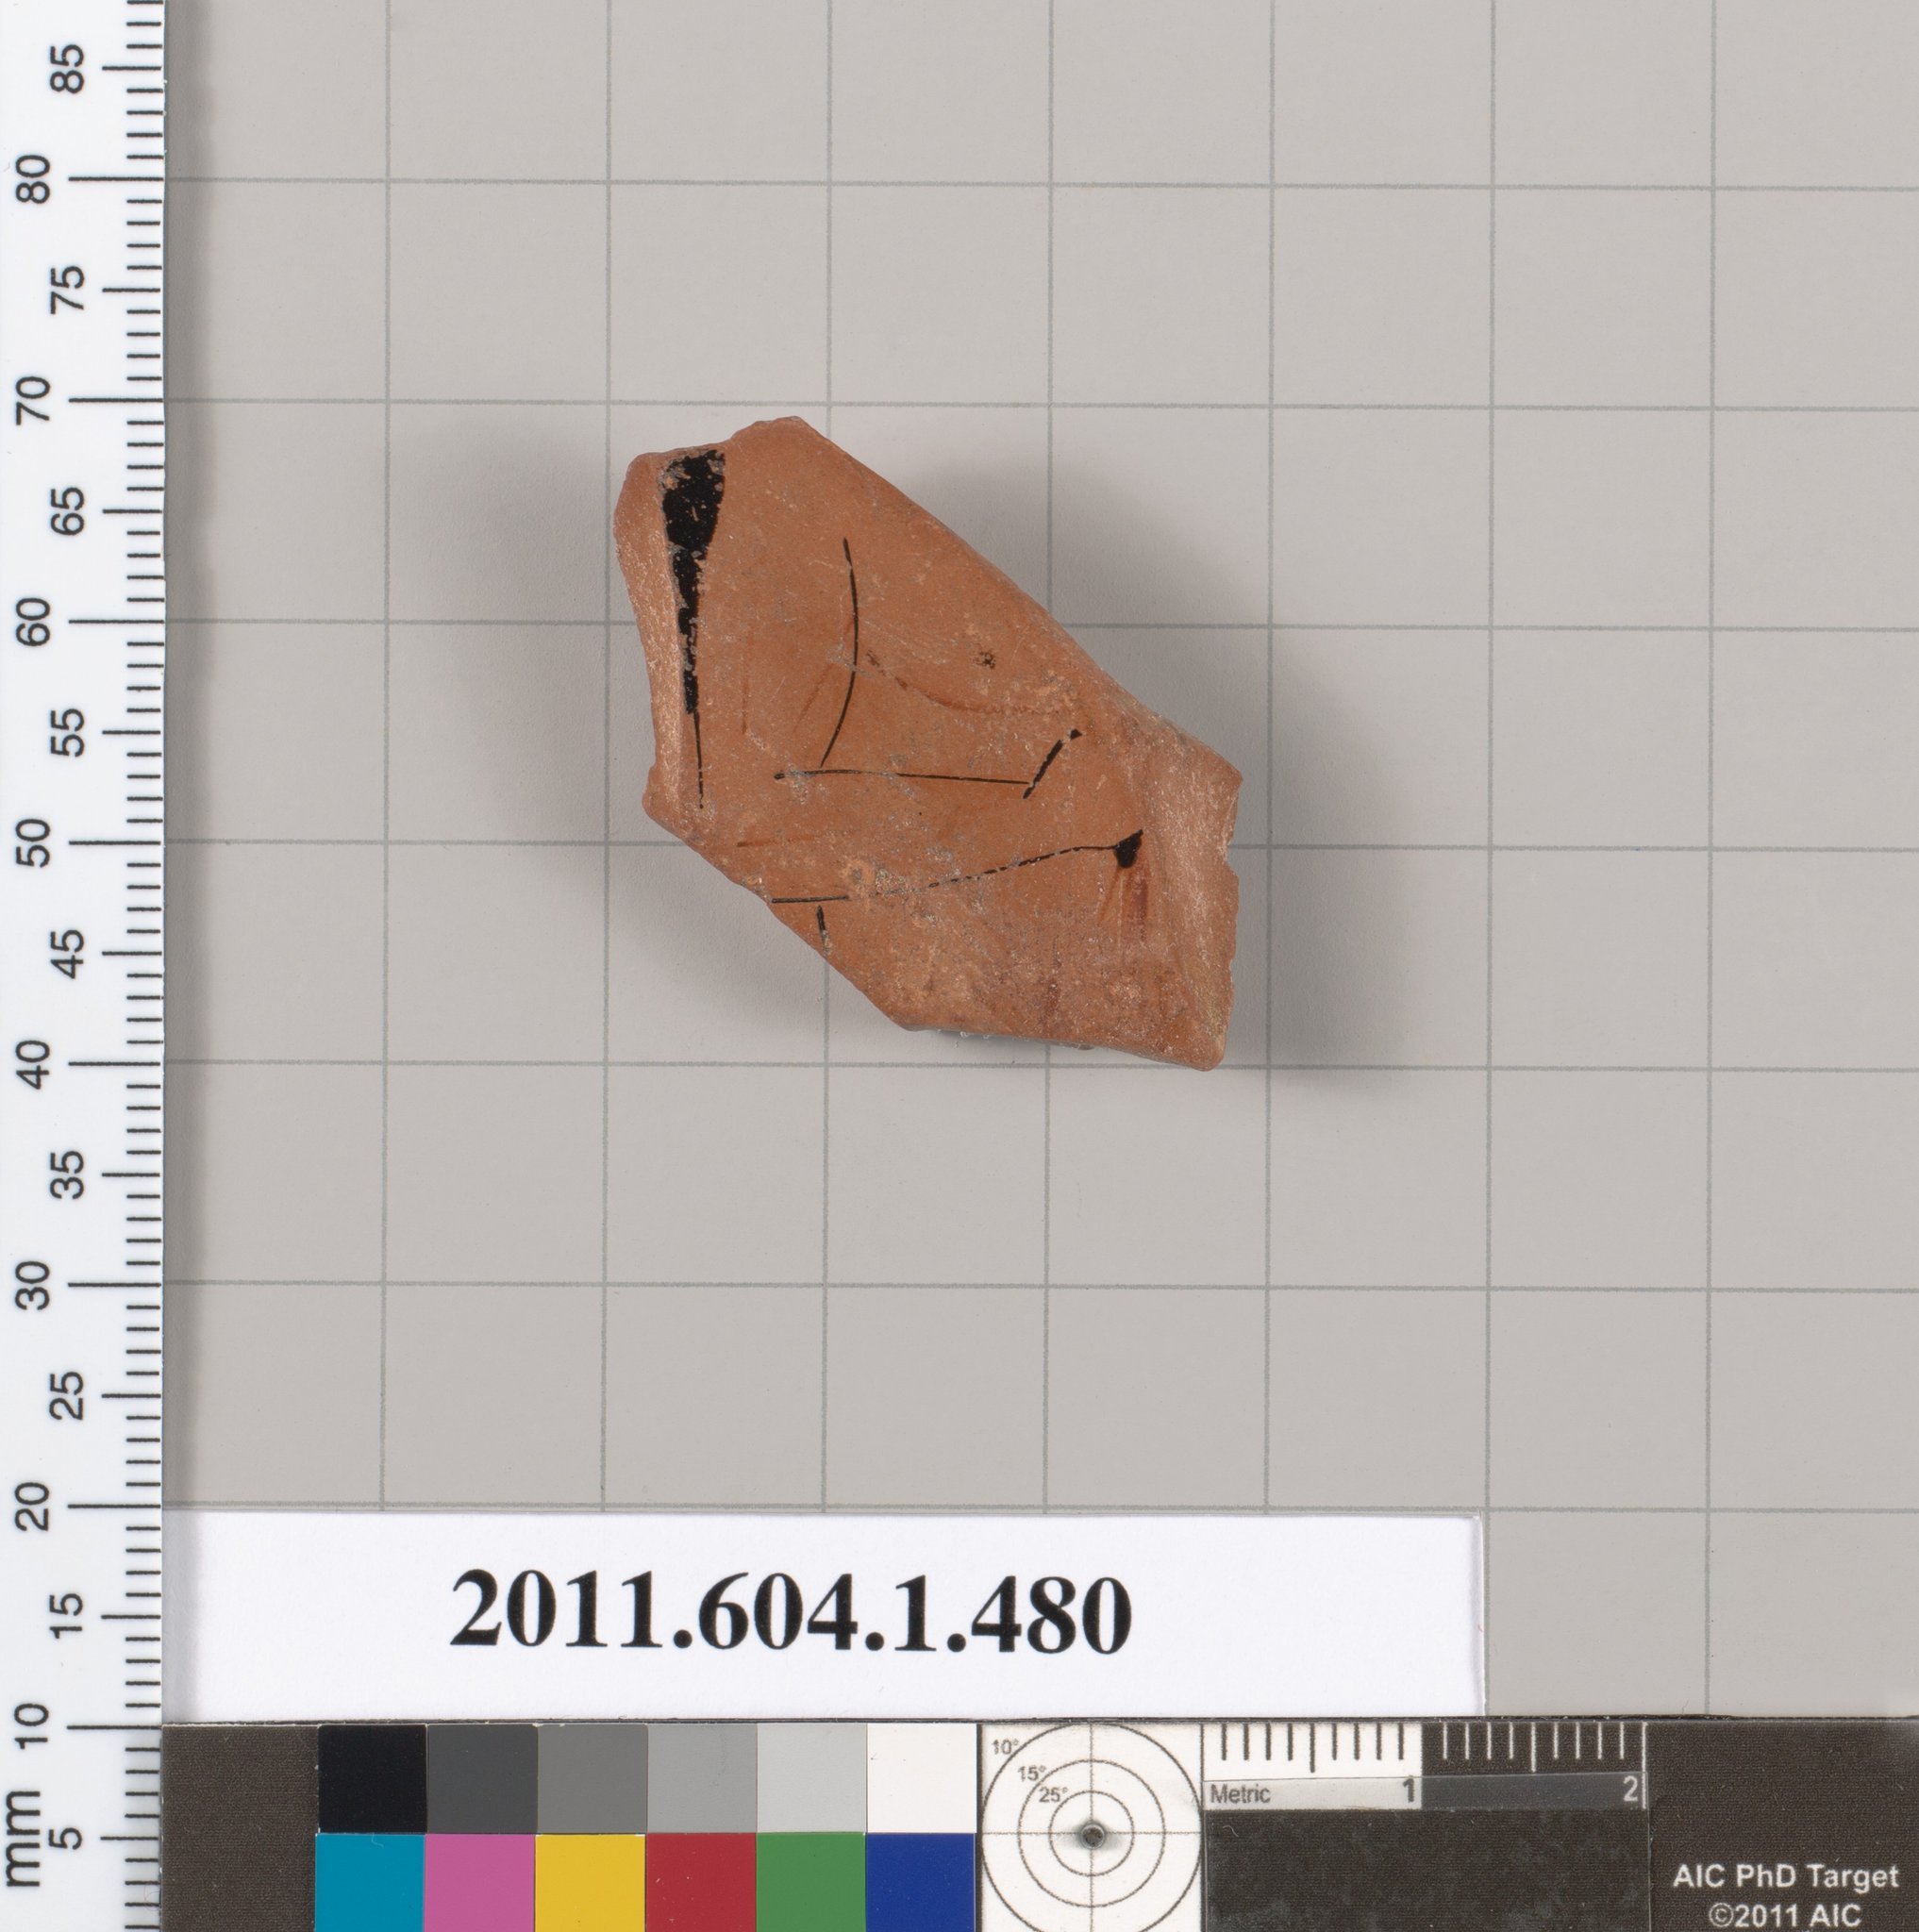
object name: kylix fragment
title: Terracotta fragment of a kylix (drinking cup)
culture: greek, attic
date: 490-480 BCE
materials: terracotta